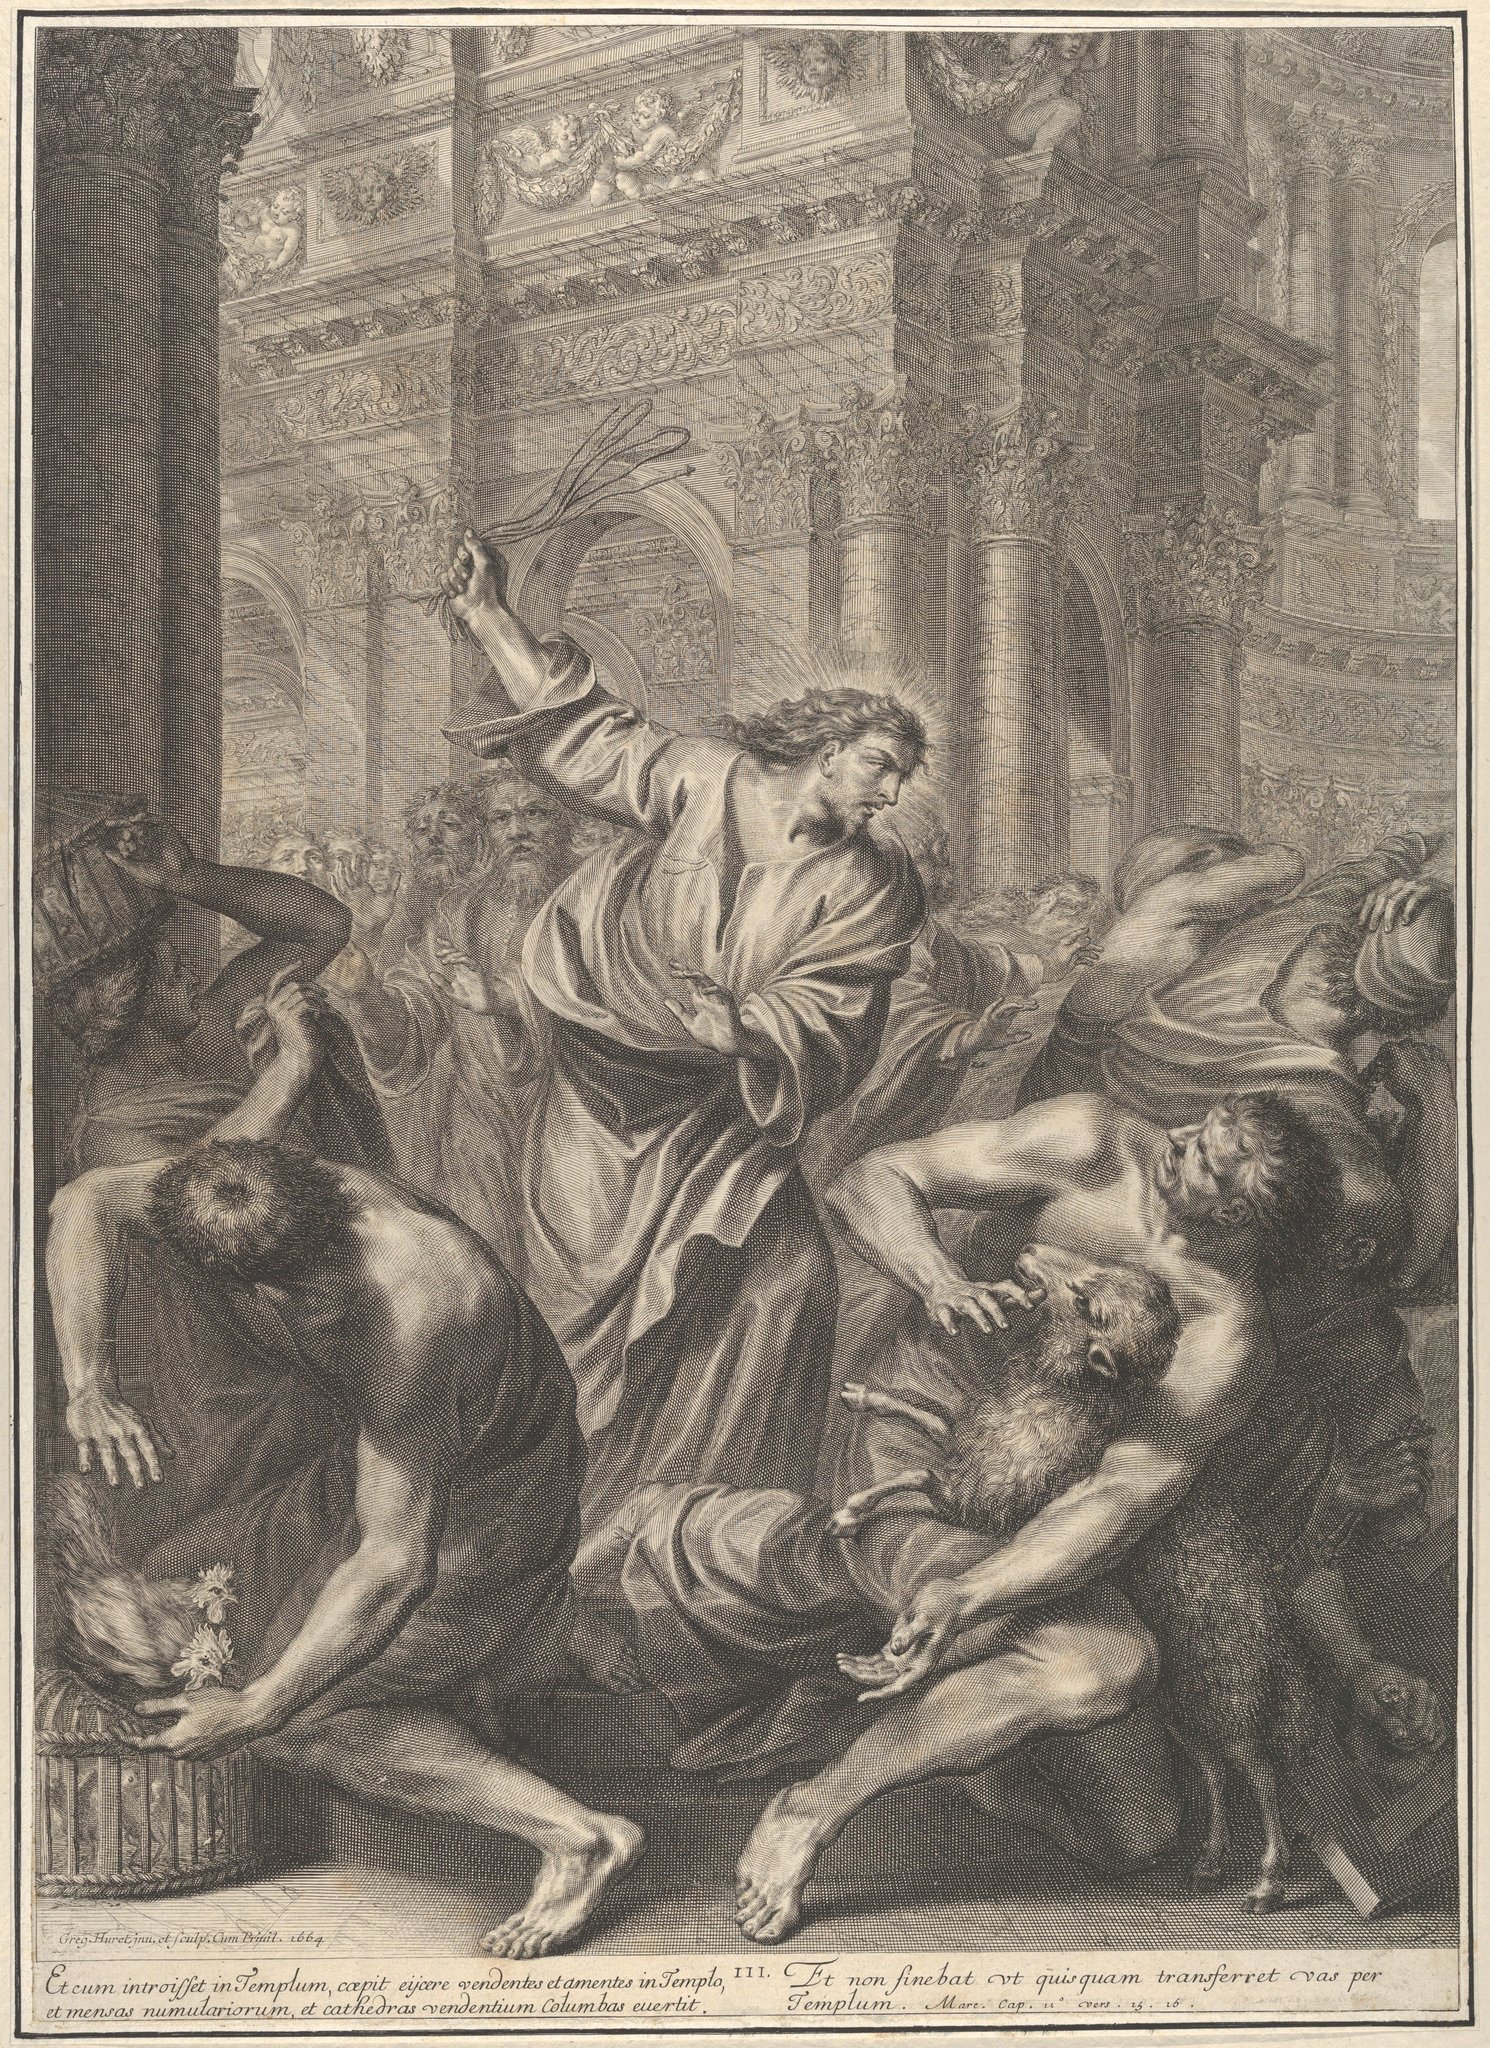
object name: print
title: Christ Driving the Merchants from the Temple, from The Passion of Christ, plate 3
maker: grégoire huret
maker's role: artist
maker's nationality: french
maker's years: 1606-1670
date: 1664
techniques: engraving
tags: animals,men,jesus,merchants